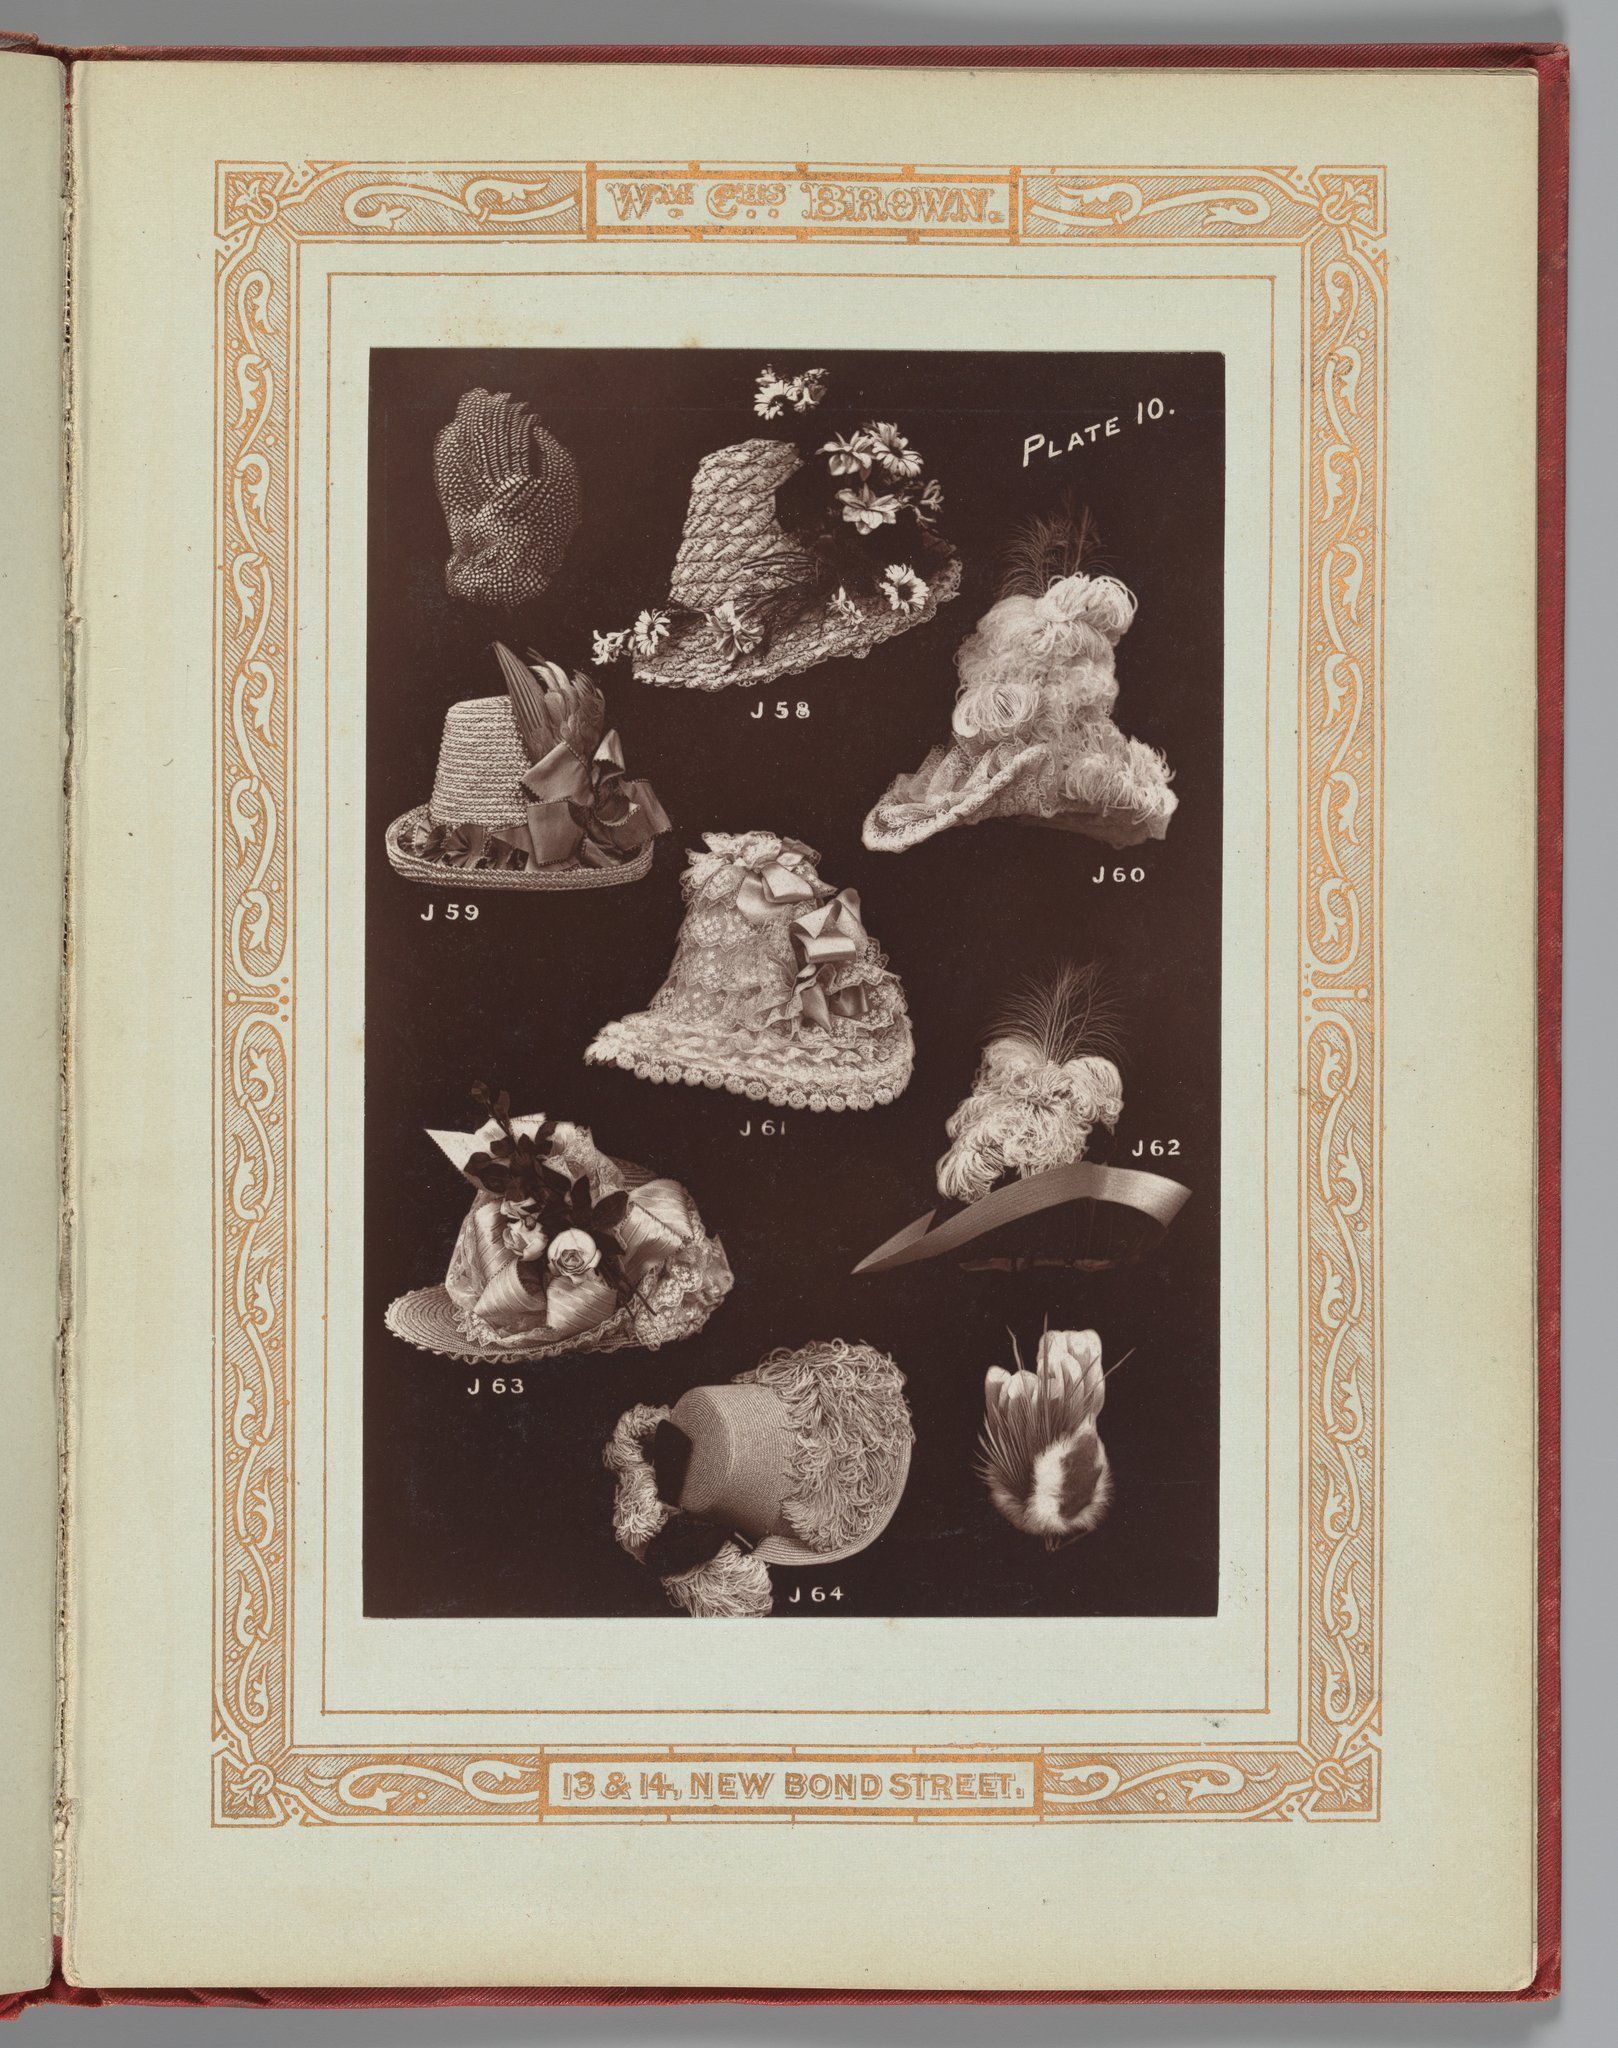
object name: photographically illustrated book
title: [Hats J58-J64]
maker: william charles brown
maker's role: author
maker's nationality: british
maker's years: 1800-1899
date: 1888